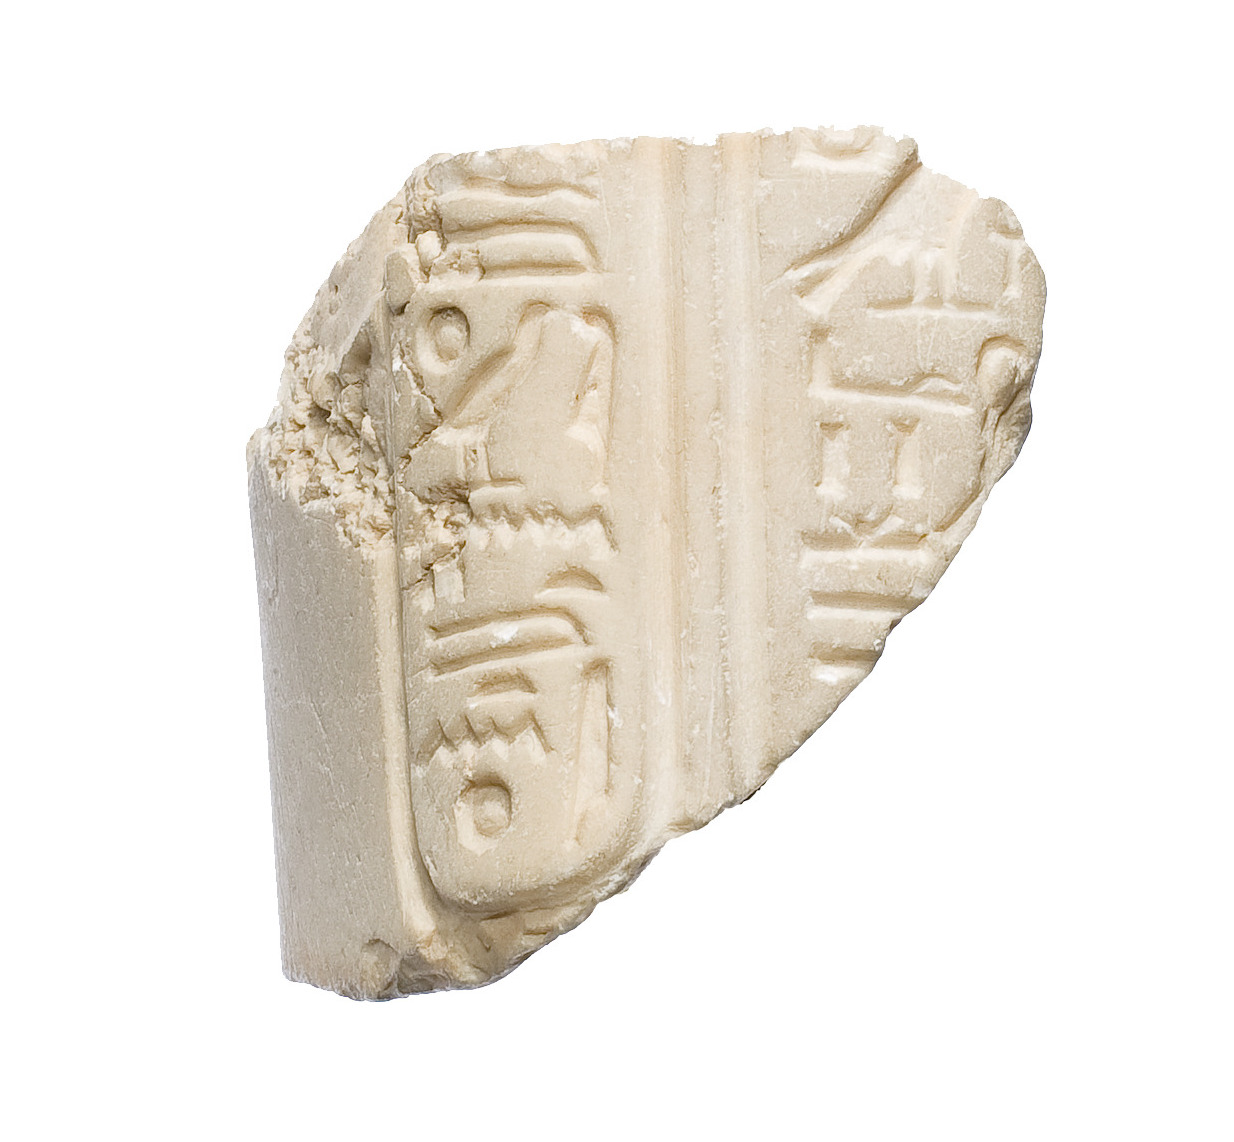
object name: arm, aten cartouch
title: Arm with Aten cartouches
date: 1353-1336 BCE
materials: limestone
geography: egypt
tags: cartouches,hieroglyphs